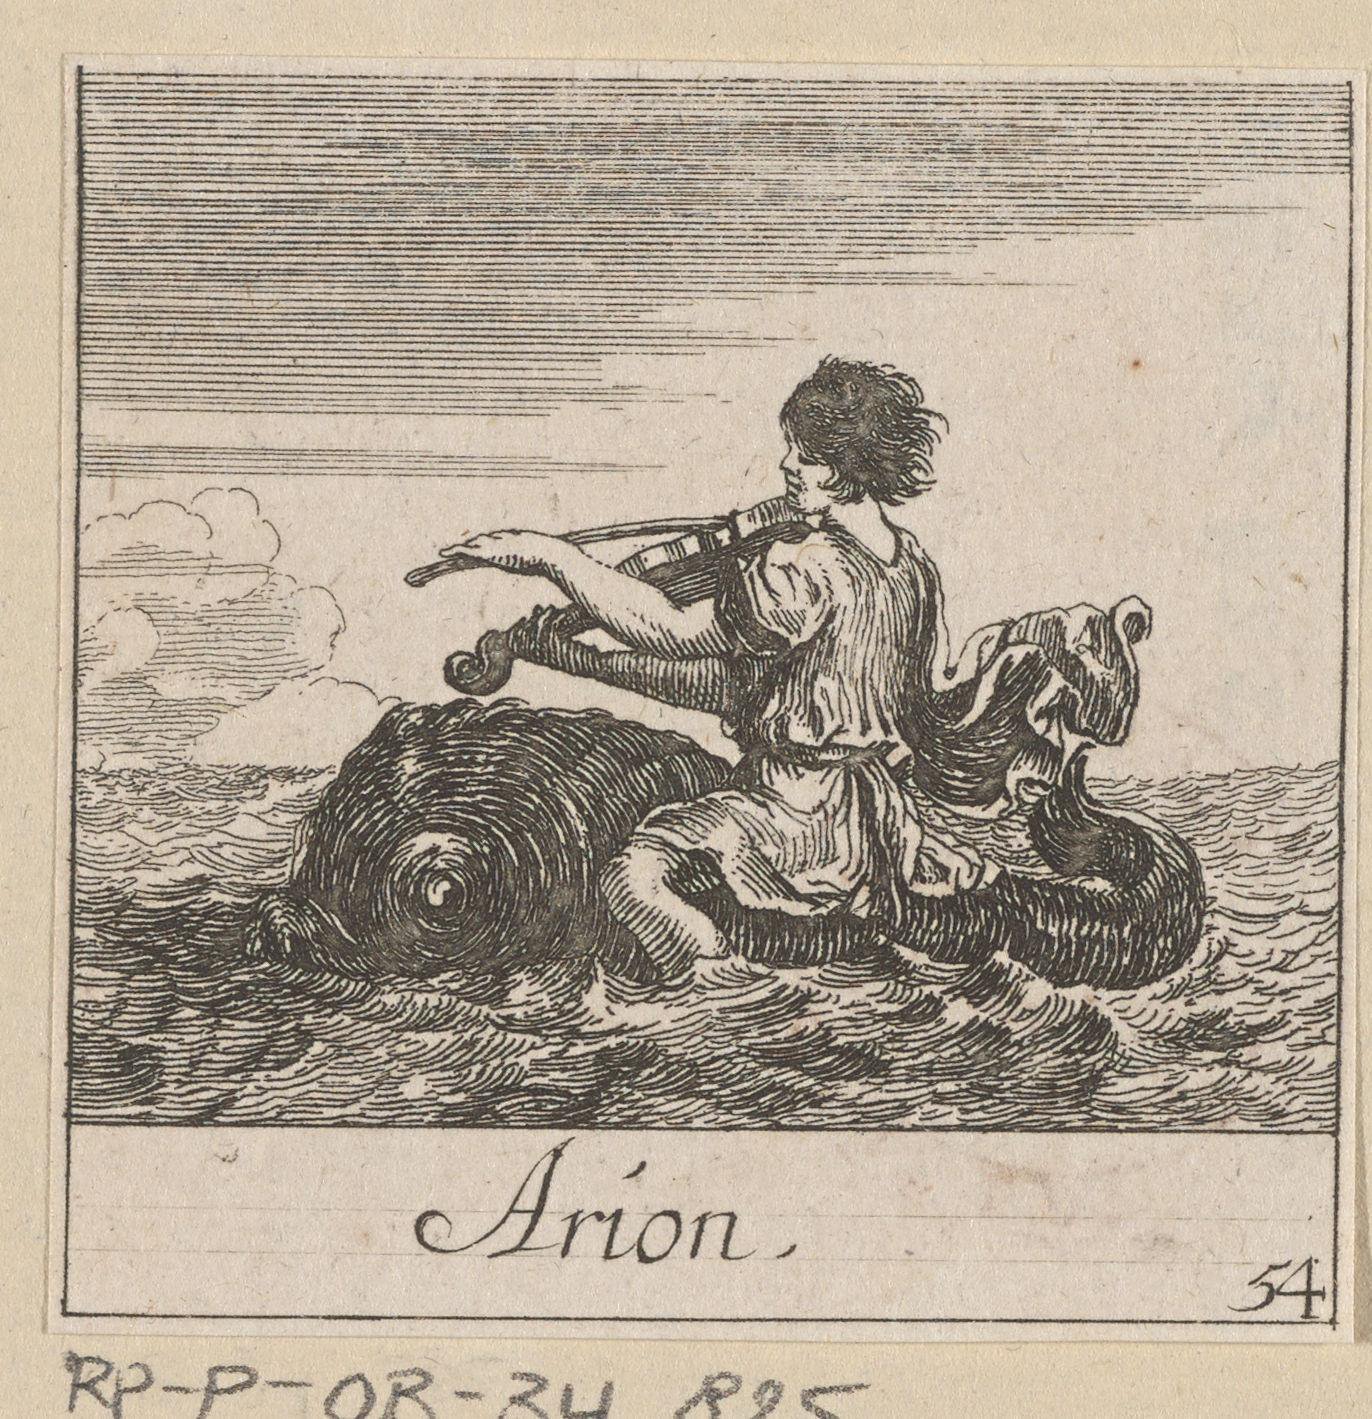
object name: playing card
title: Kaartspel met mythologische voorstellingen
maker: Anonymous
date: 1620-1664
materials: paper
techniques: etching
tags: (story of) arion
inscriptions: collector's mark: Lugt 240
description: Prent uit een reeks van 54 genummerde speelkaarten met voorstellingen uit de Metamorfosen van Ovidius.